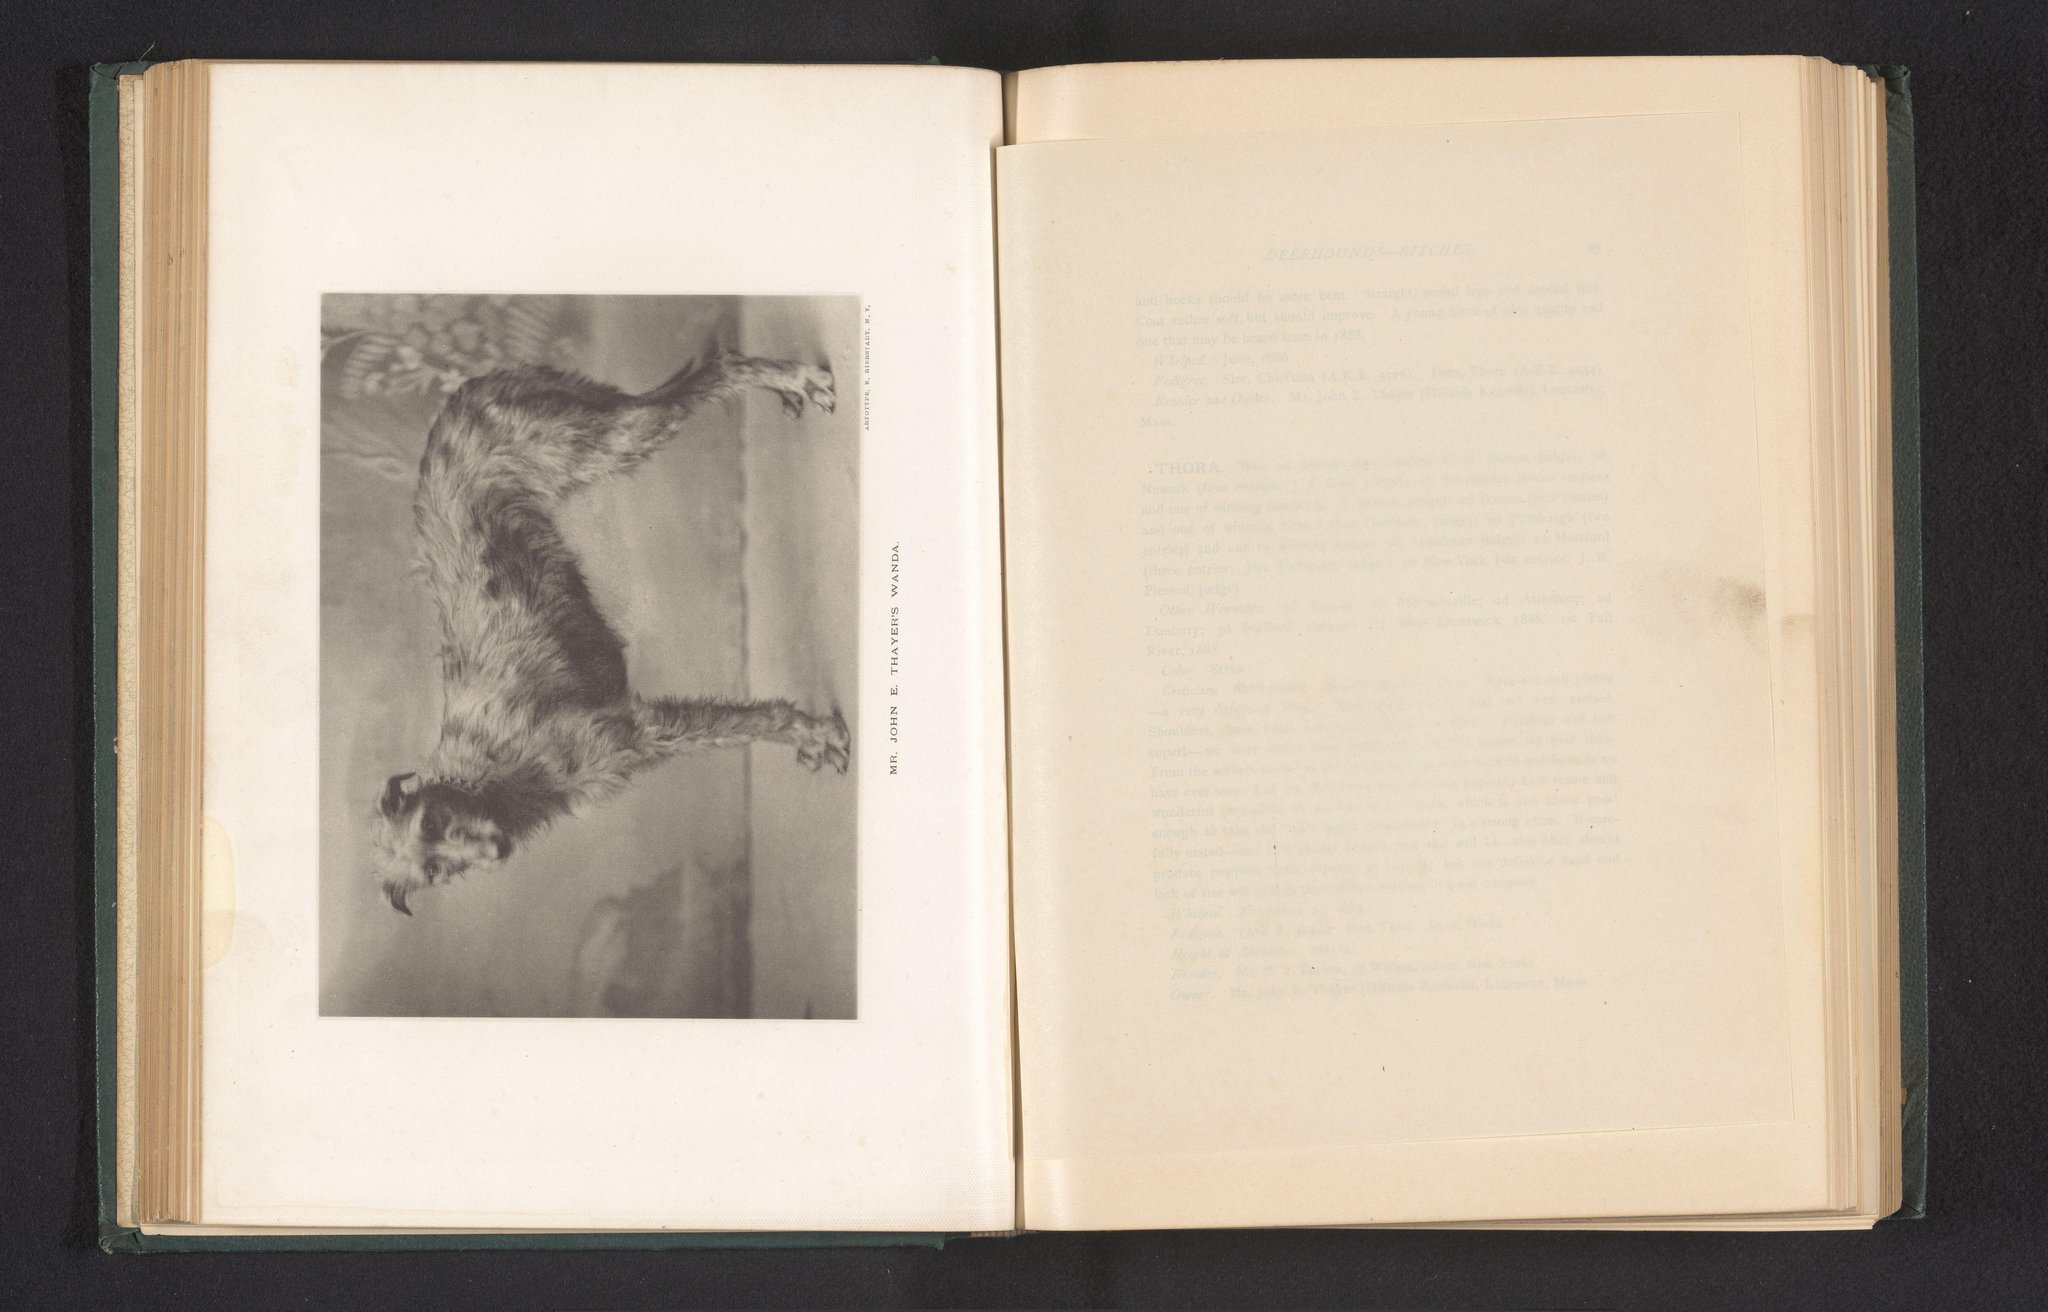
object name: page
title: Mr. John E. Thayer's Wanda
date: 1883-1888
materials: paper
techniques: photograph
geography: new york city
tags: dog (with name of kind)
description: Prent tegenover pagina 95, achter semi-transparante omslag.